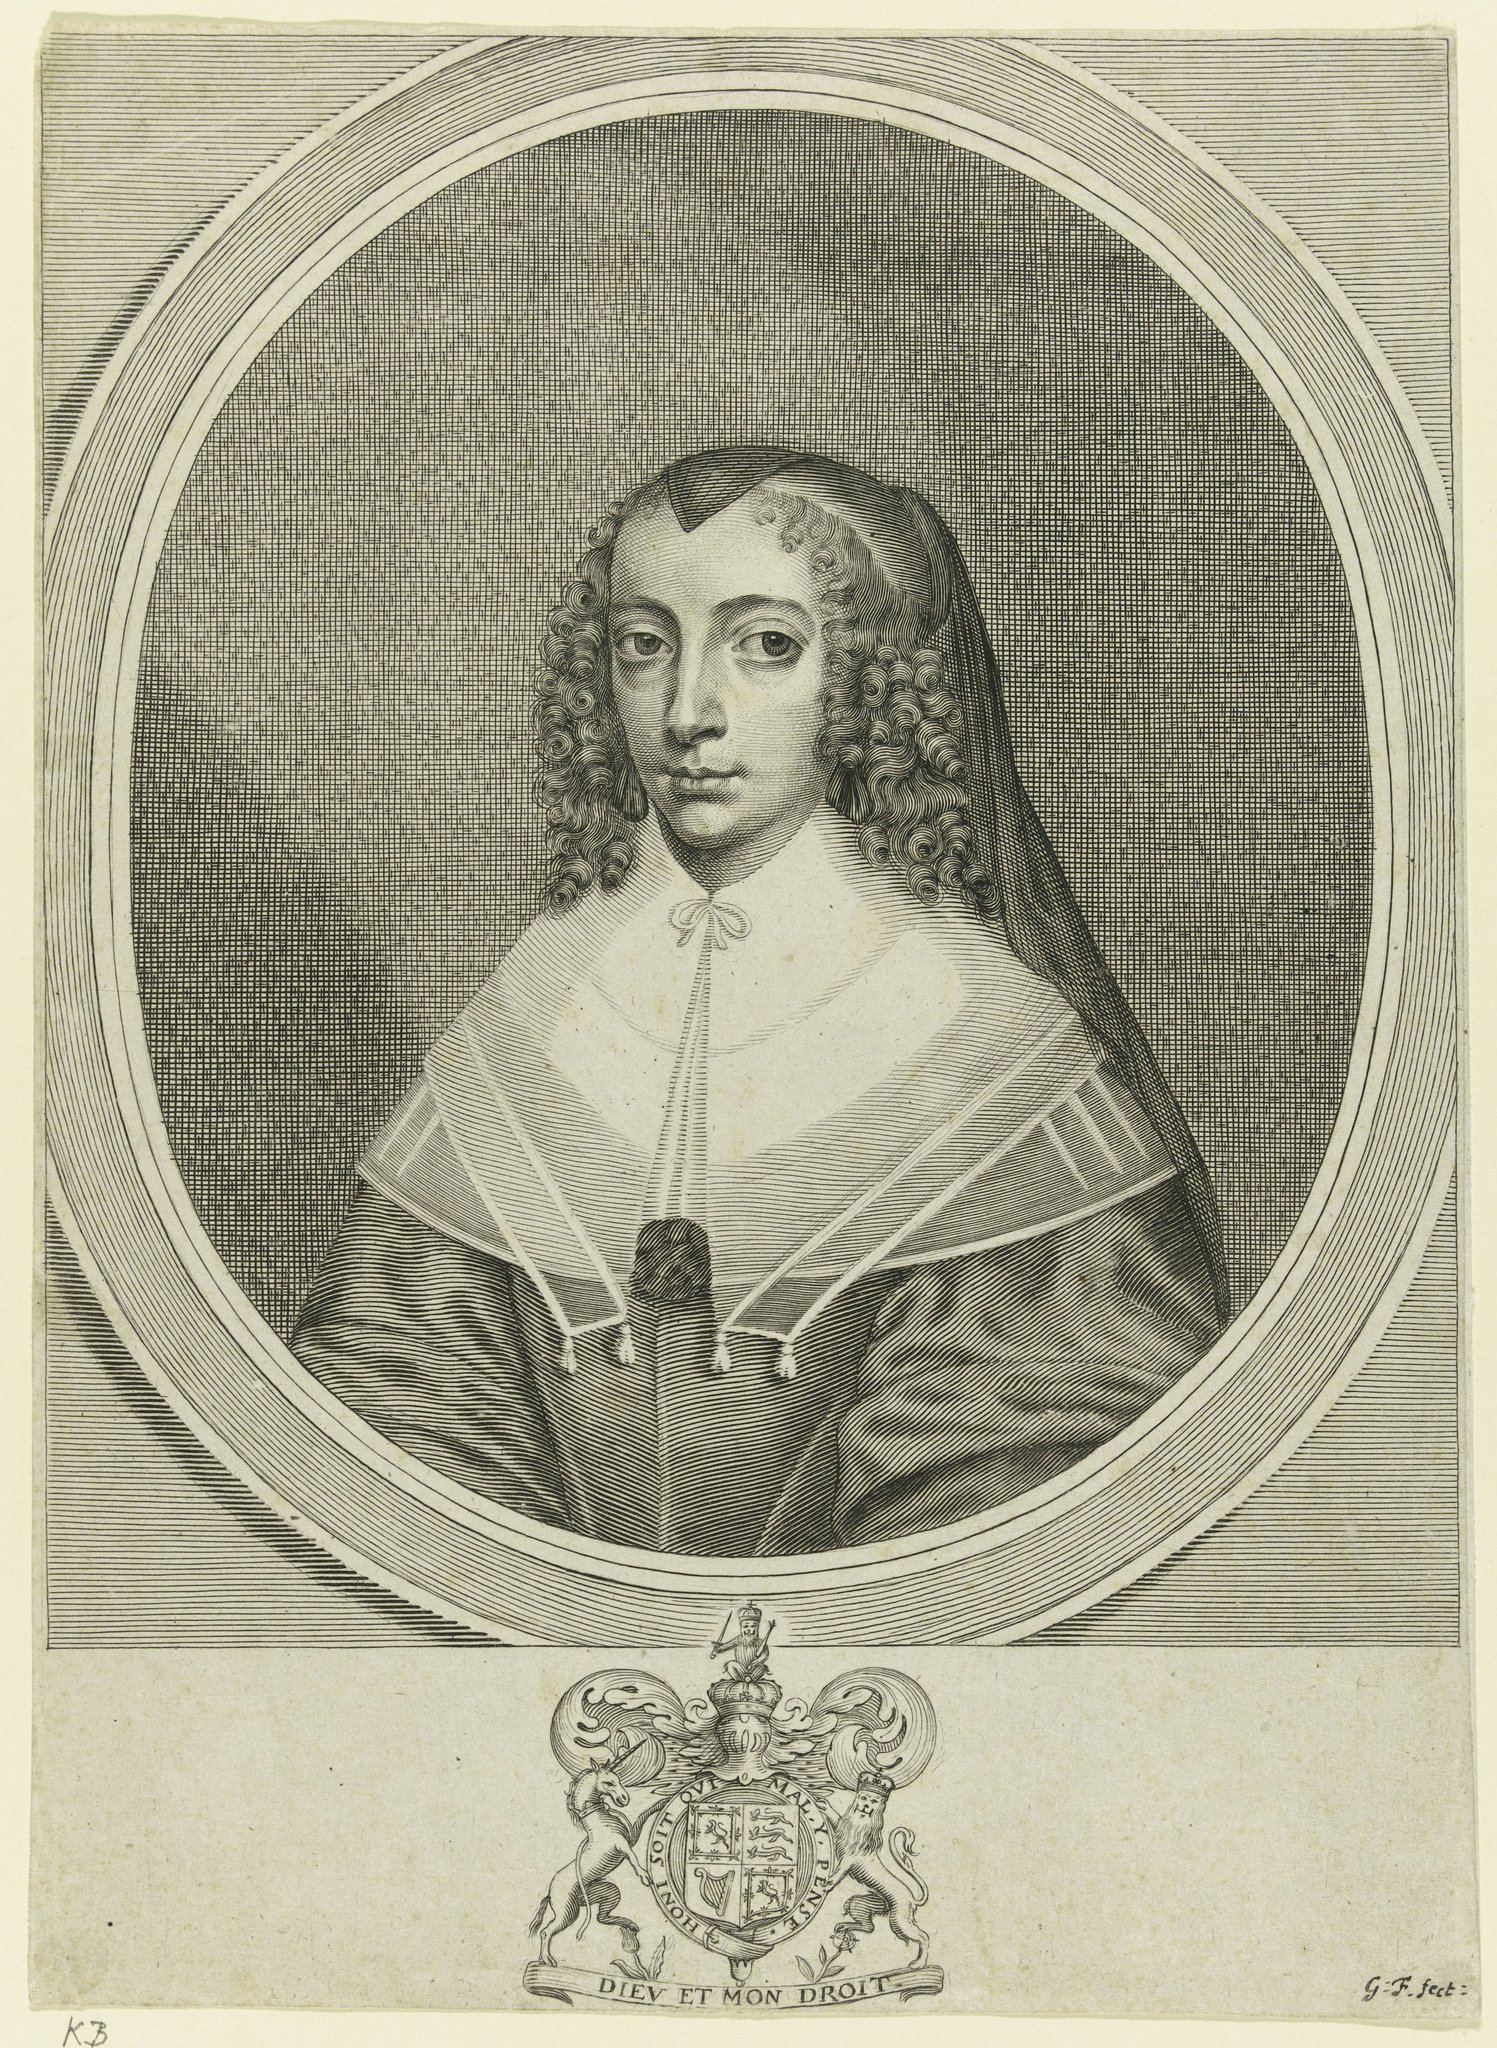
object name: print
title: Portret van Maria Henrietta Stuart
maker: monogrammist gf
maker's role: print maker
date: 1650-1749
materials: paper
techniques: engraving, etching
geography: germany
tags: london, mary henrietta stuart, knighthood order (garter) - insignia of a knighthood order, e.g.: badge, chain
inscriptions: collector's mark: Lugt 240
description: Portret van Maria Henrietta in een ovaal. In de ondermarge haar wapen gedecoreerd met de Kousenband en het devies van de Orde van de Kousenband.